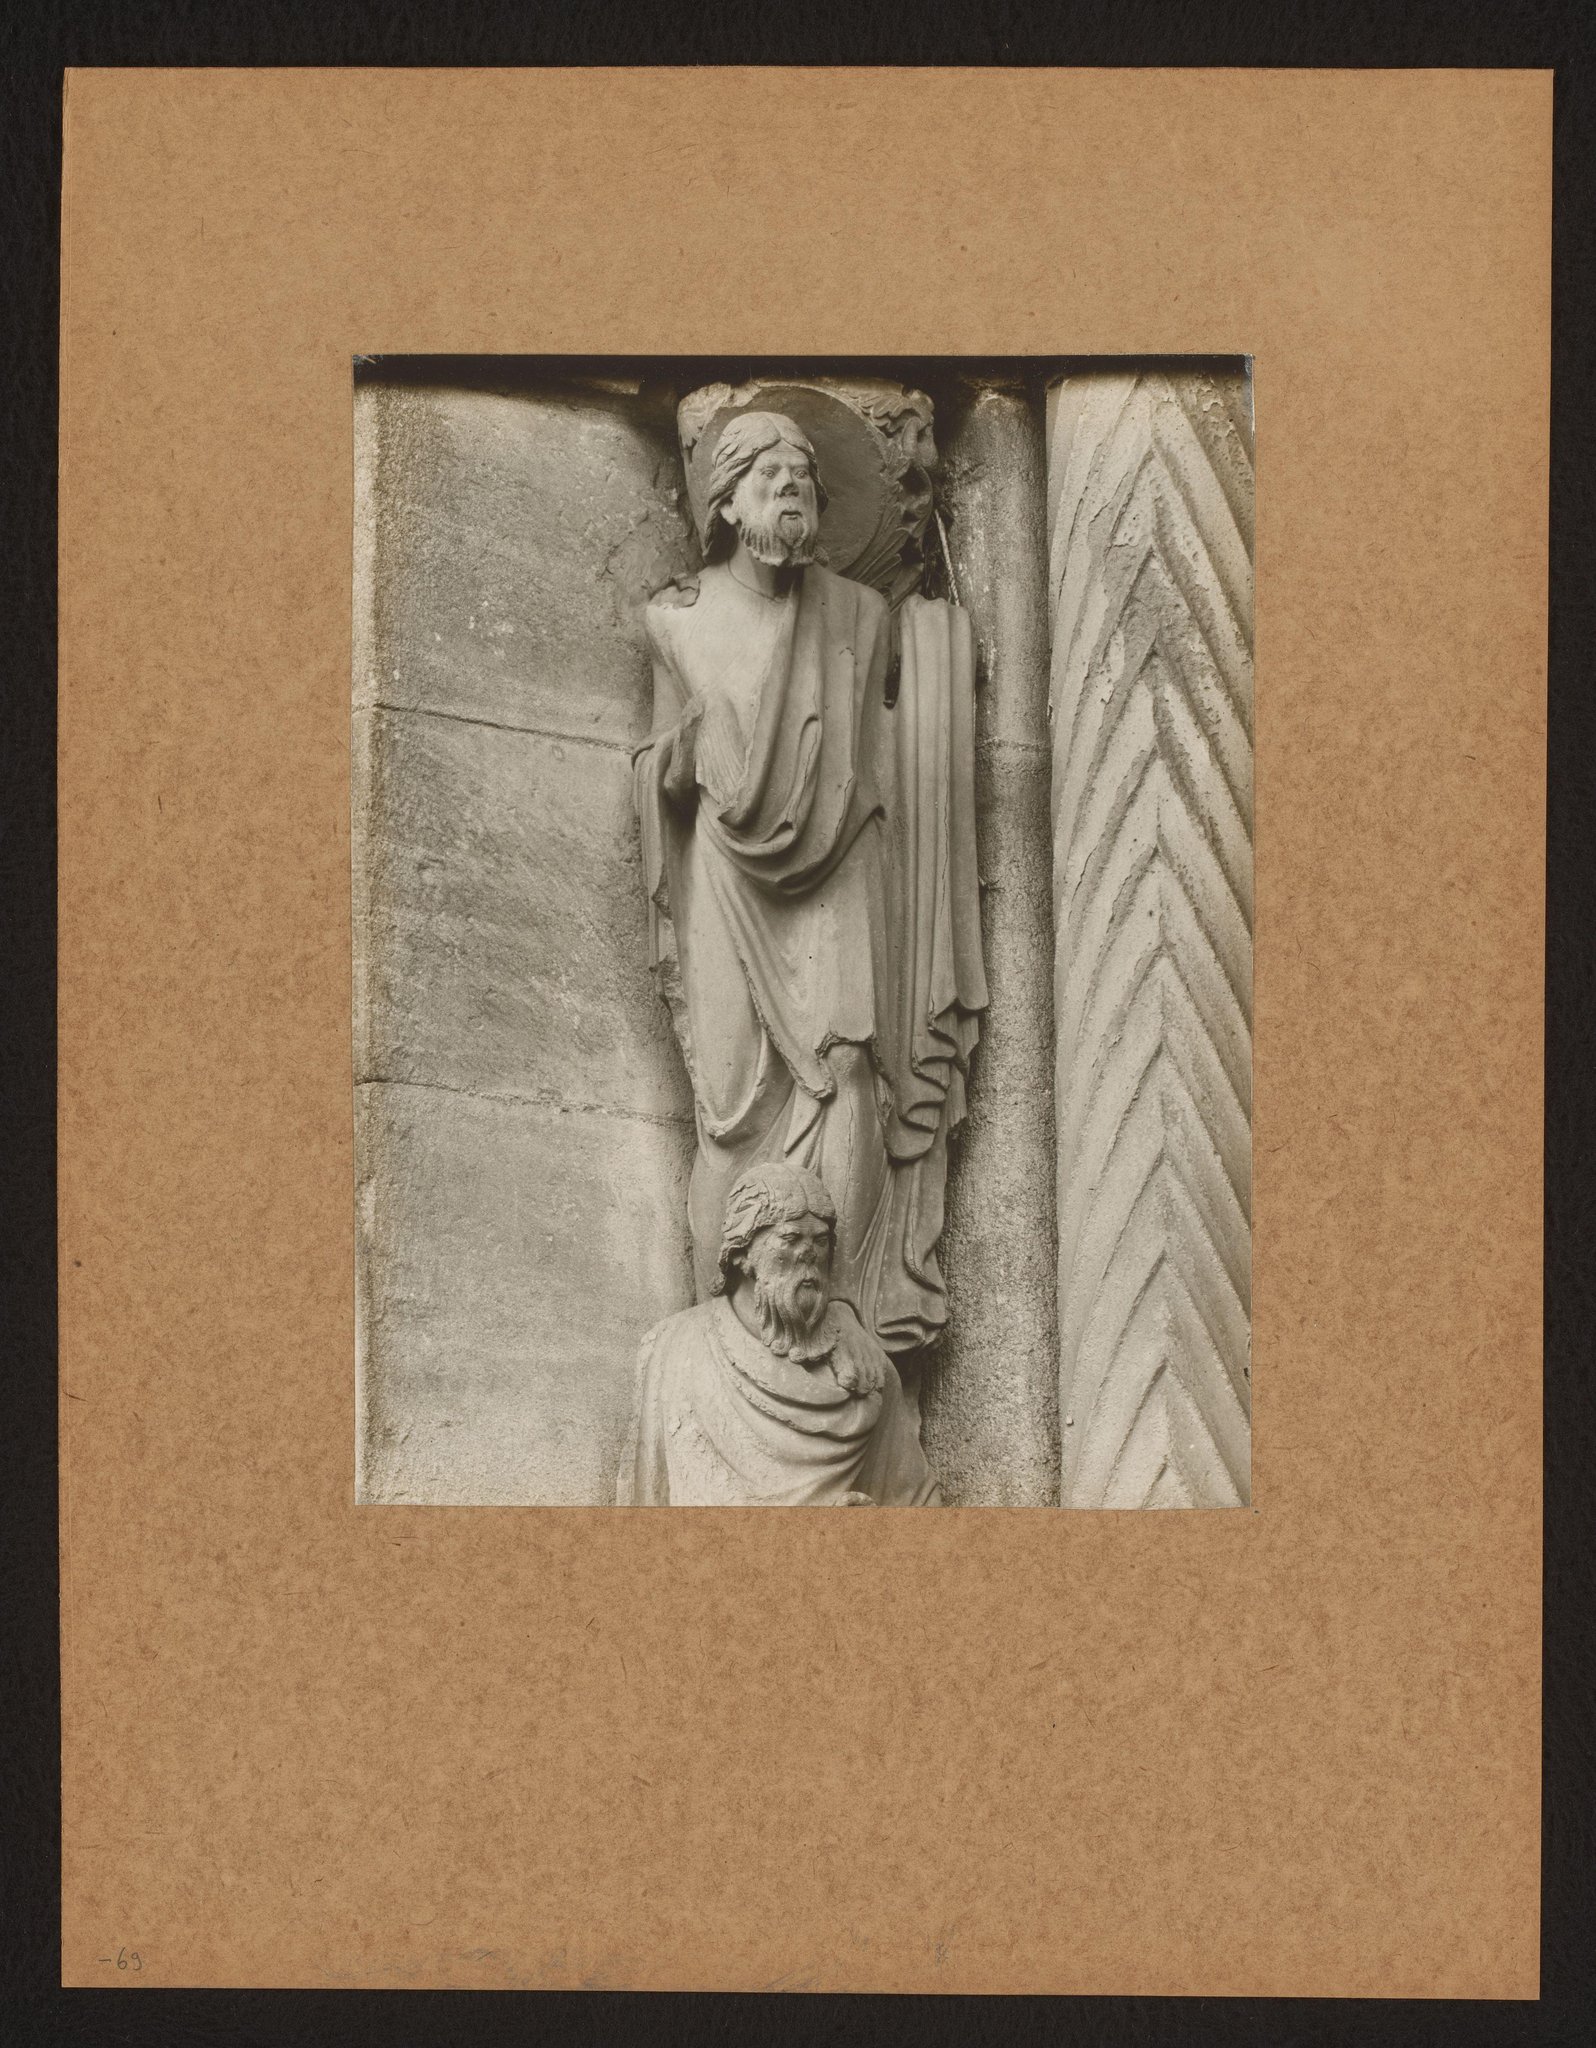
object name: album leaf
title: Detail van de Fürstenportal in de dom van Bamberg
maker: Anonymous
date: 1900-1920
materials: paper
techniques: gelatin silver print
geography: bamberg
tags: church (exterior)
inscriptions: number: ‘71’